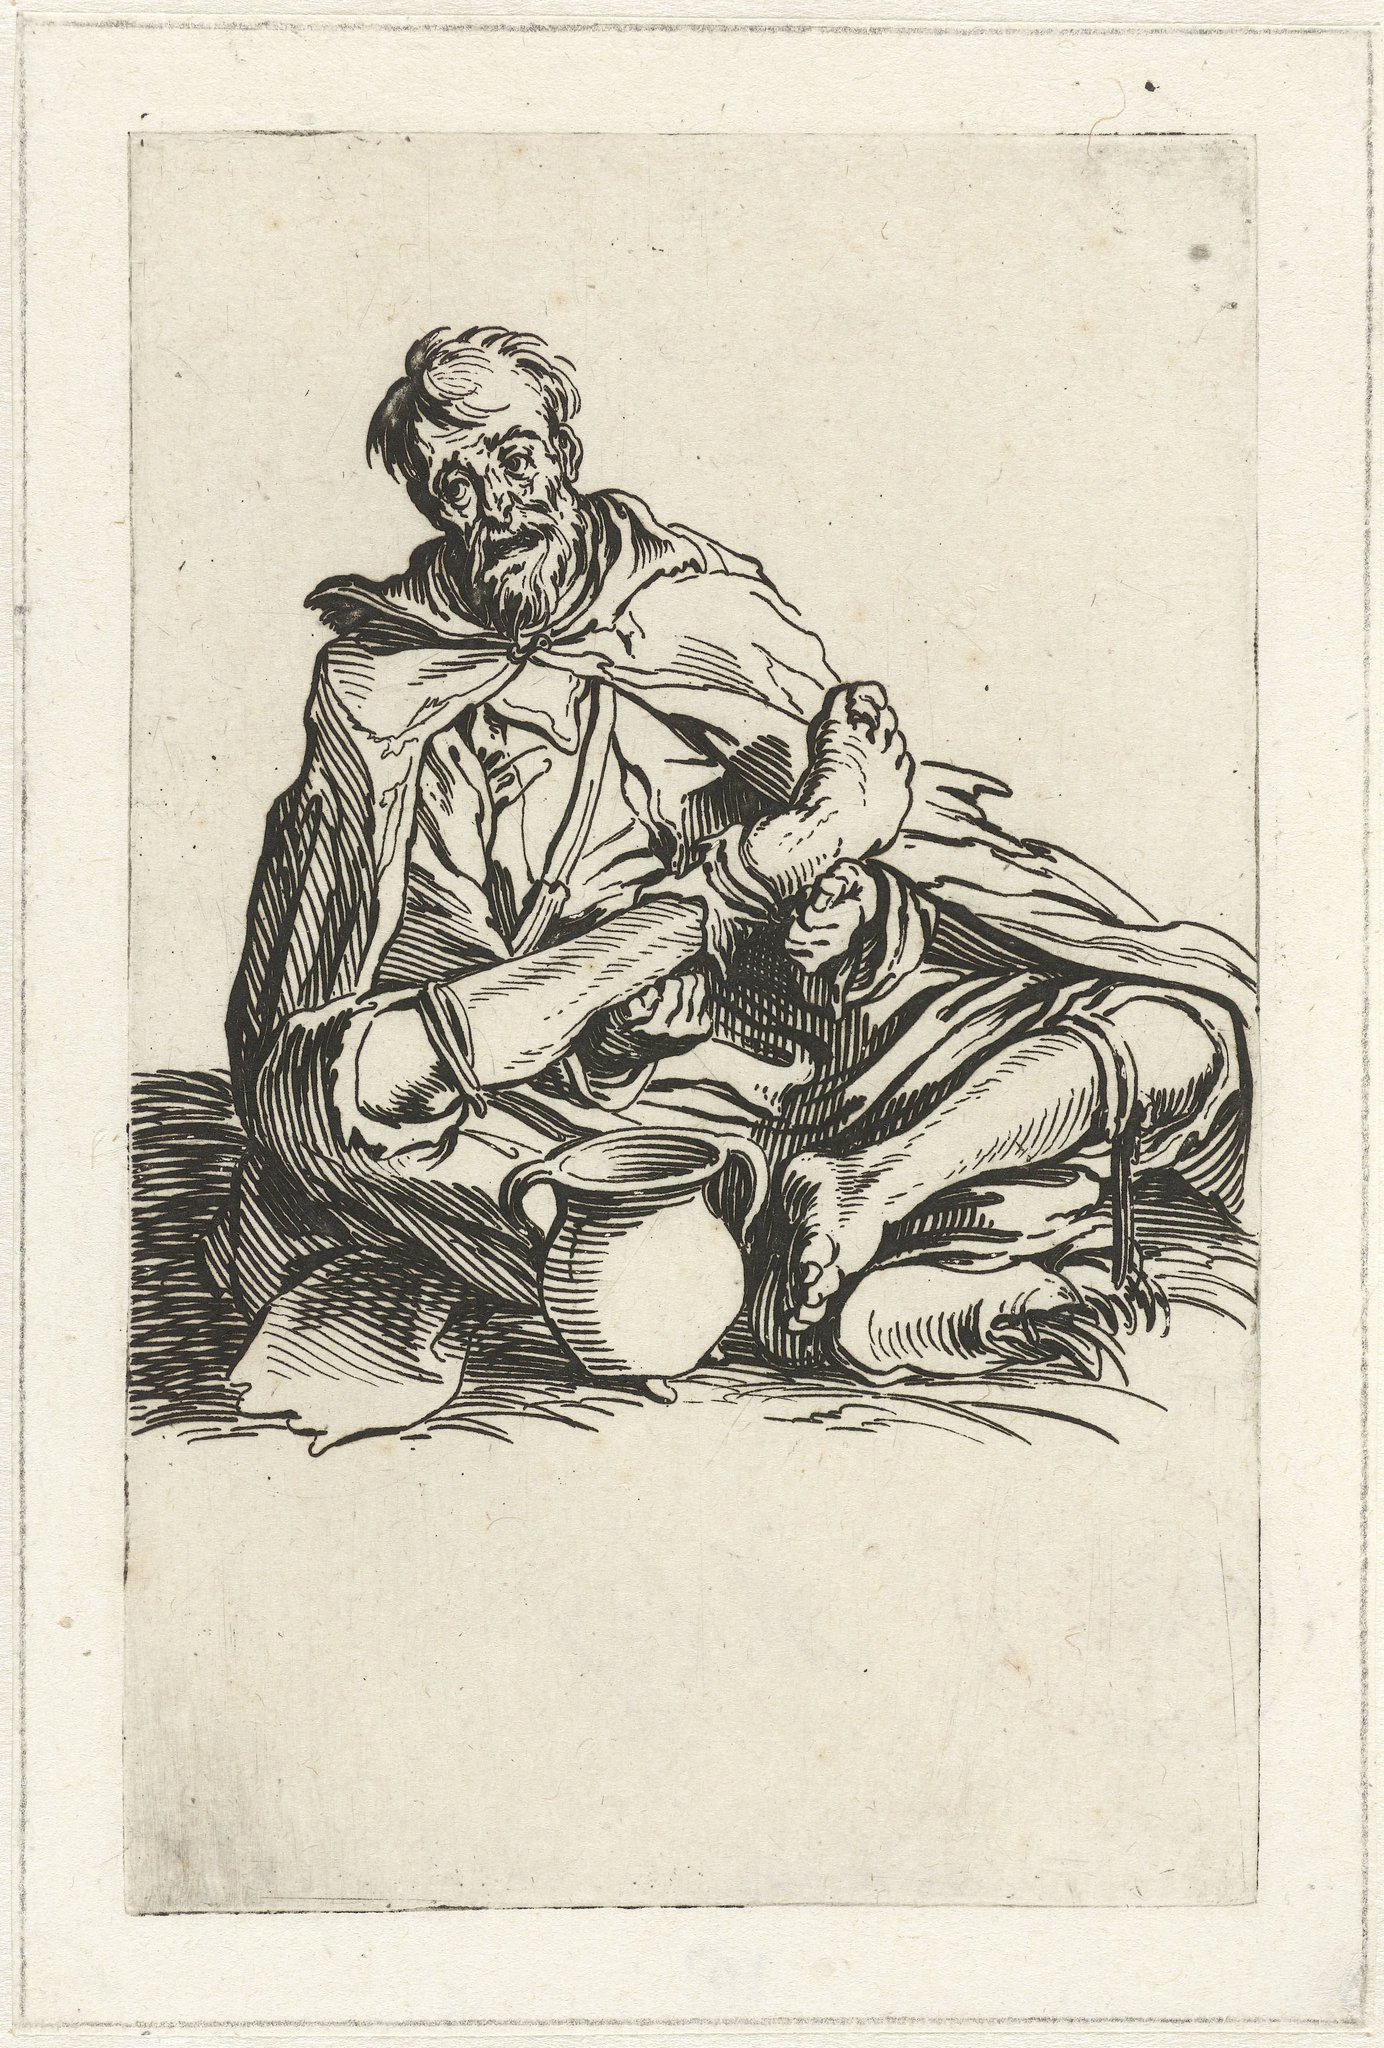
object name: print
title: Les Gueux / Les Mendiants / Les Baroni / Les Barons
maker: jacques callot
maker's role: draughtsman, print maker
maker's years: 1592-1635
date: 1622-1623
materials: paper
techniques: etching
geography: nancy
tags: sitting cross-legged, as tailor at work, standing, leaning, sitting or lying with legs crossed, container of ceramics: jar, jug, pot, vase, beggar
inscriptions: collector's mark: Lugt 240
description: Man, gekleed in lompen, van voren gezien, zittend met gekruiste benen, het rechterbeen met de handen iets opheffend, een kruik bij de linkervoet. Deze prent is onderdeel van een serie van 25 prenten met bedelaars en zwervers, zoals Callot die waarschijnlijk in Italië heeft gezien.